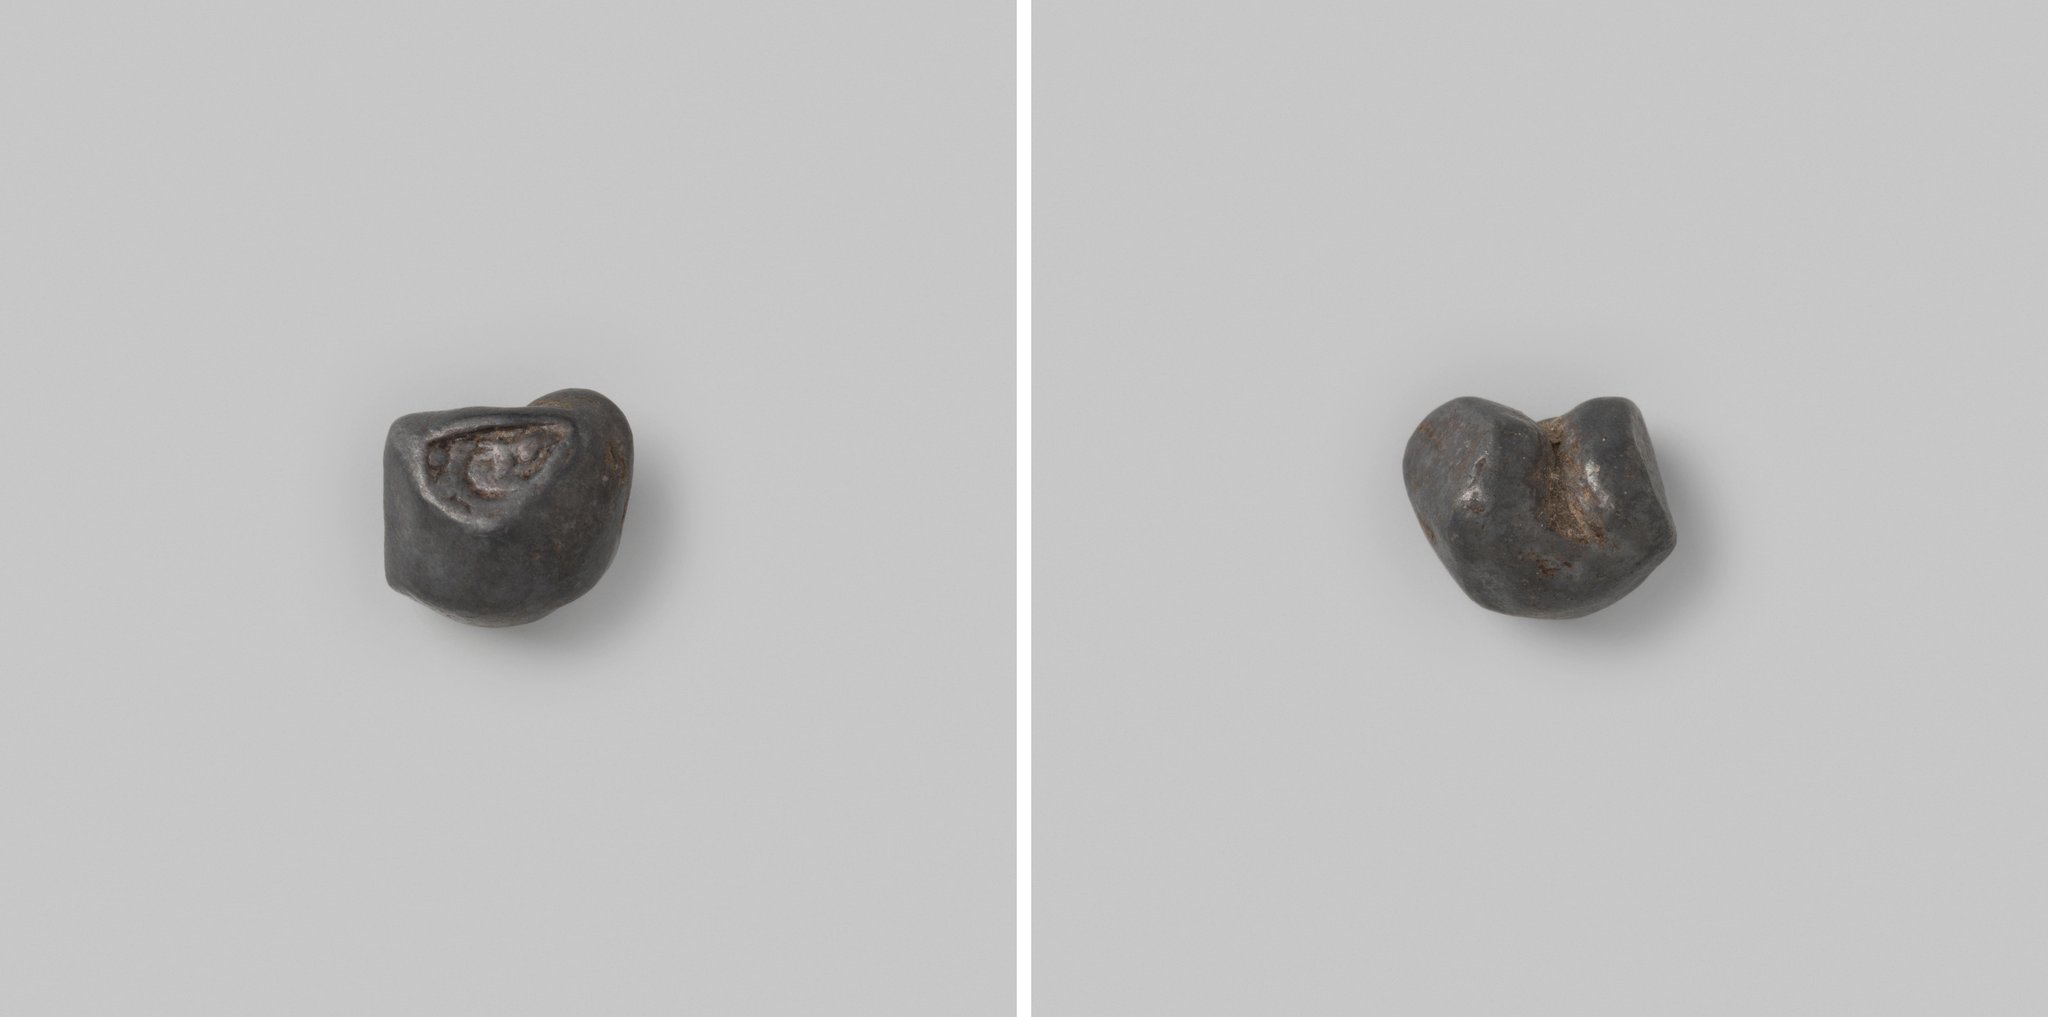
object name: coin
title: 1/8 tical of fuang uit Thailand,1650-1850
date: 1650-1850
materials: silver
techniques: casting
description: Zilveren, korrelvormige munt. voorzien van één instempeling (kra): vishaak [?].